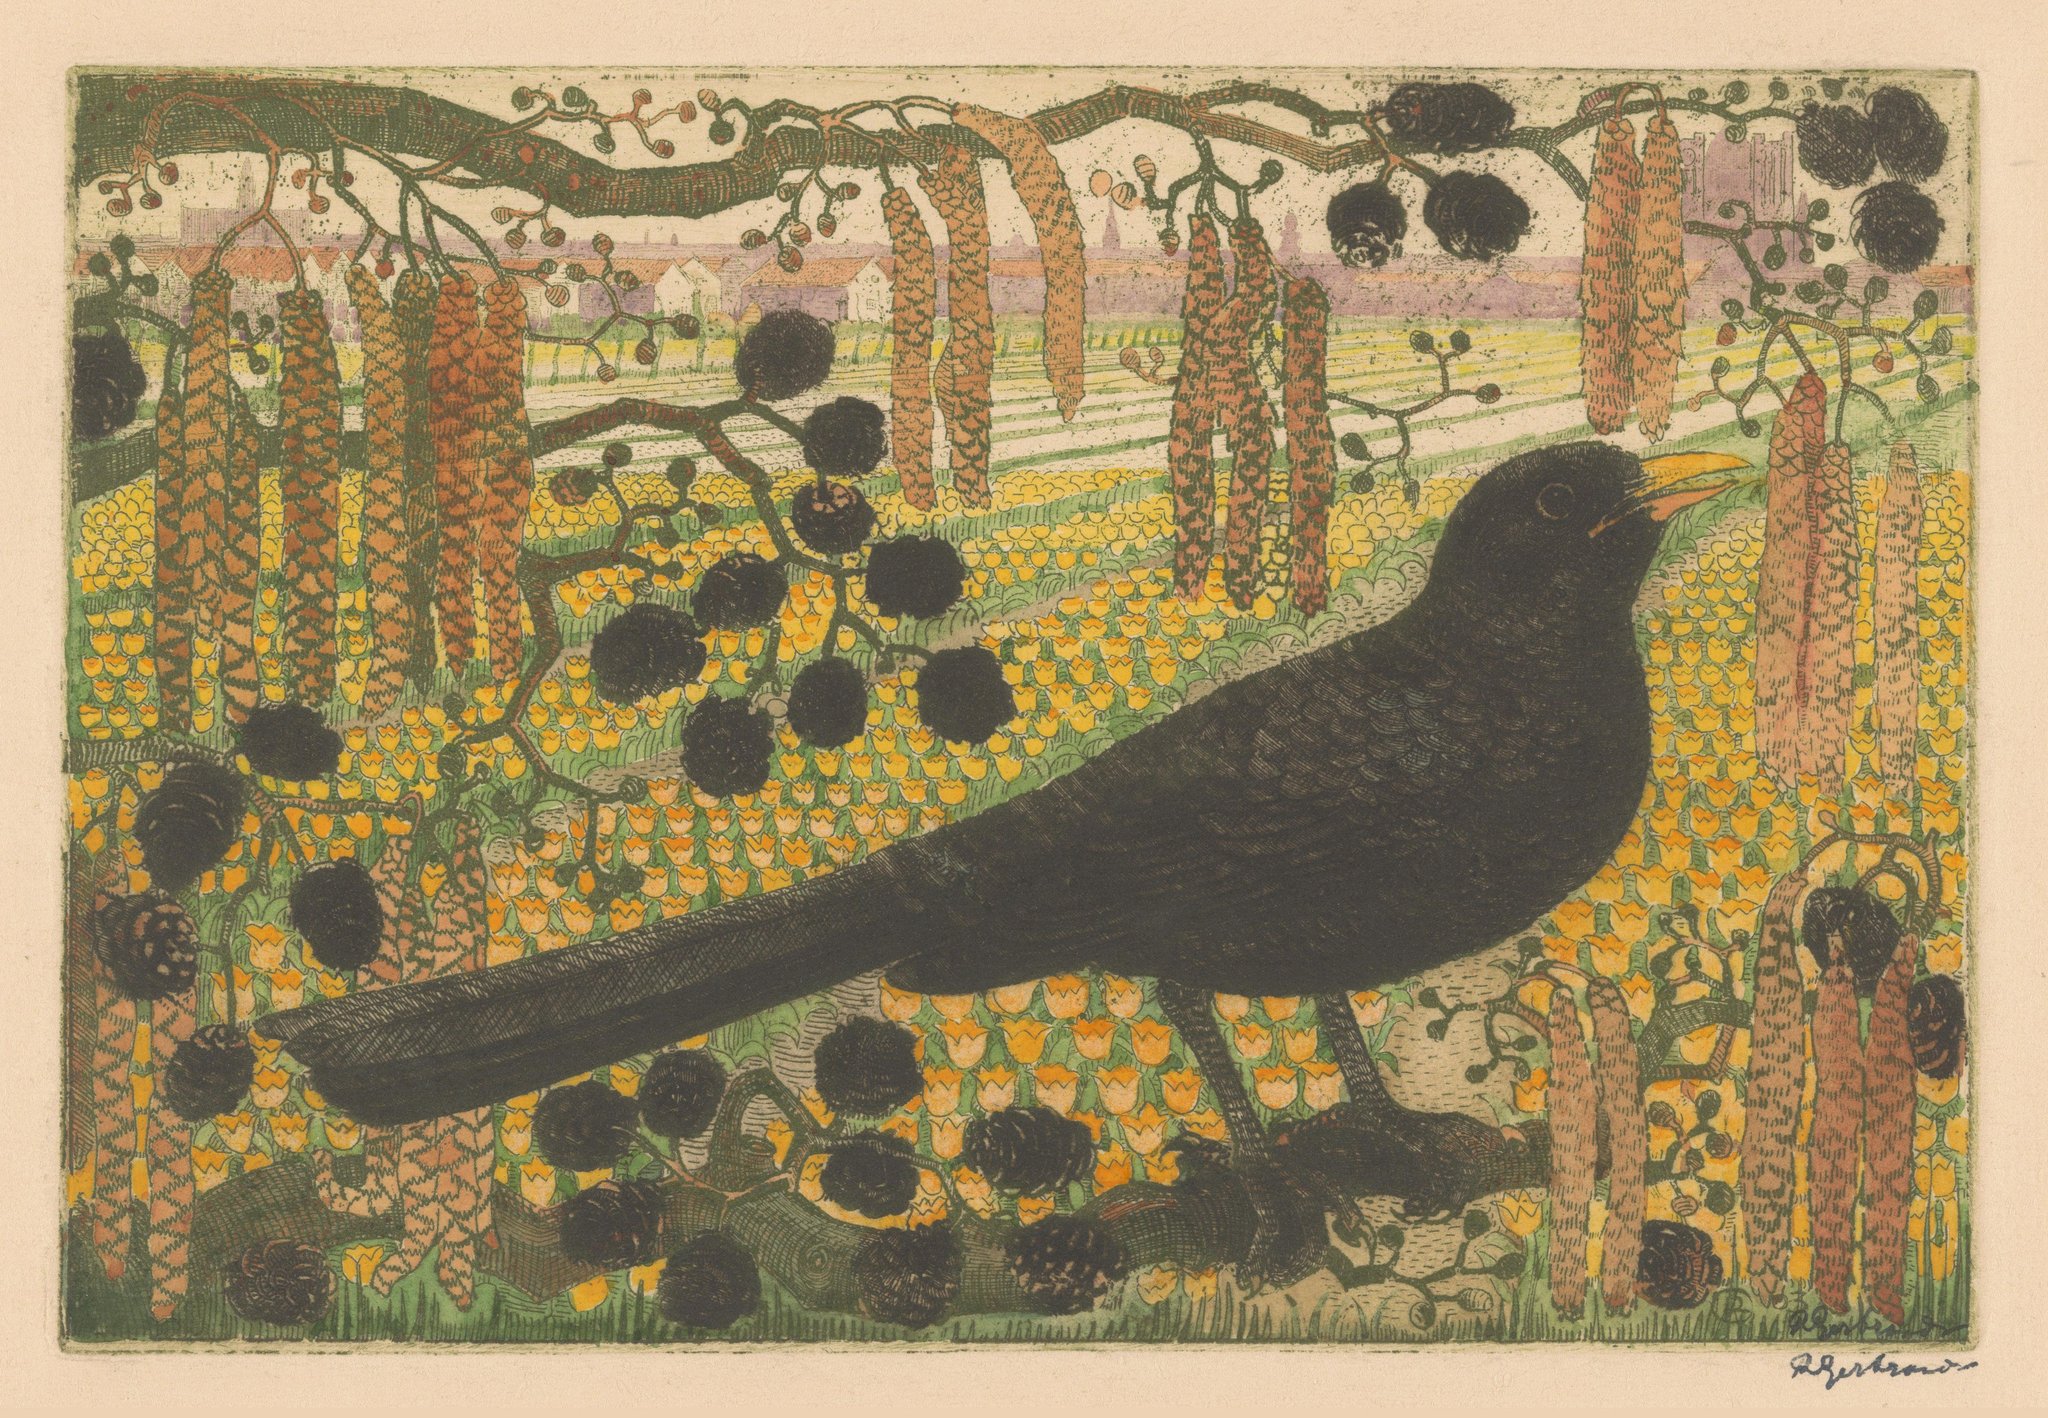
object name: print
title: Merel in een boom bij een tulpenveld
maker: roelf gerbrands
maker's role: designer, draughtsman, print maker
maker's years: 1891-1954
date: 1901-1931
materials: paper, watercolor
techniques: etching, hand coloring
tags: trees (+ branch, stick), flowers: tulip, prospect of city, town panorama, silhouette of city, song-birds: blackbird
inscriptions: collector's mark: Lugt 2228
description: Op de achtergrond een stad, mogelijk Haarlem.